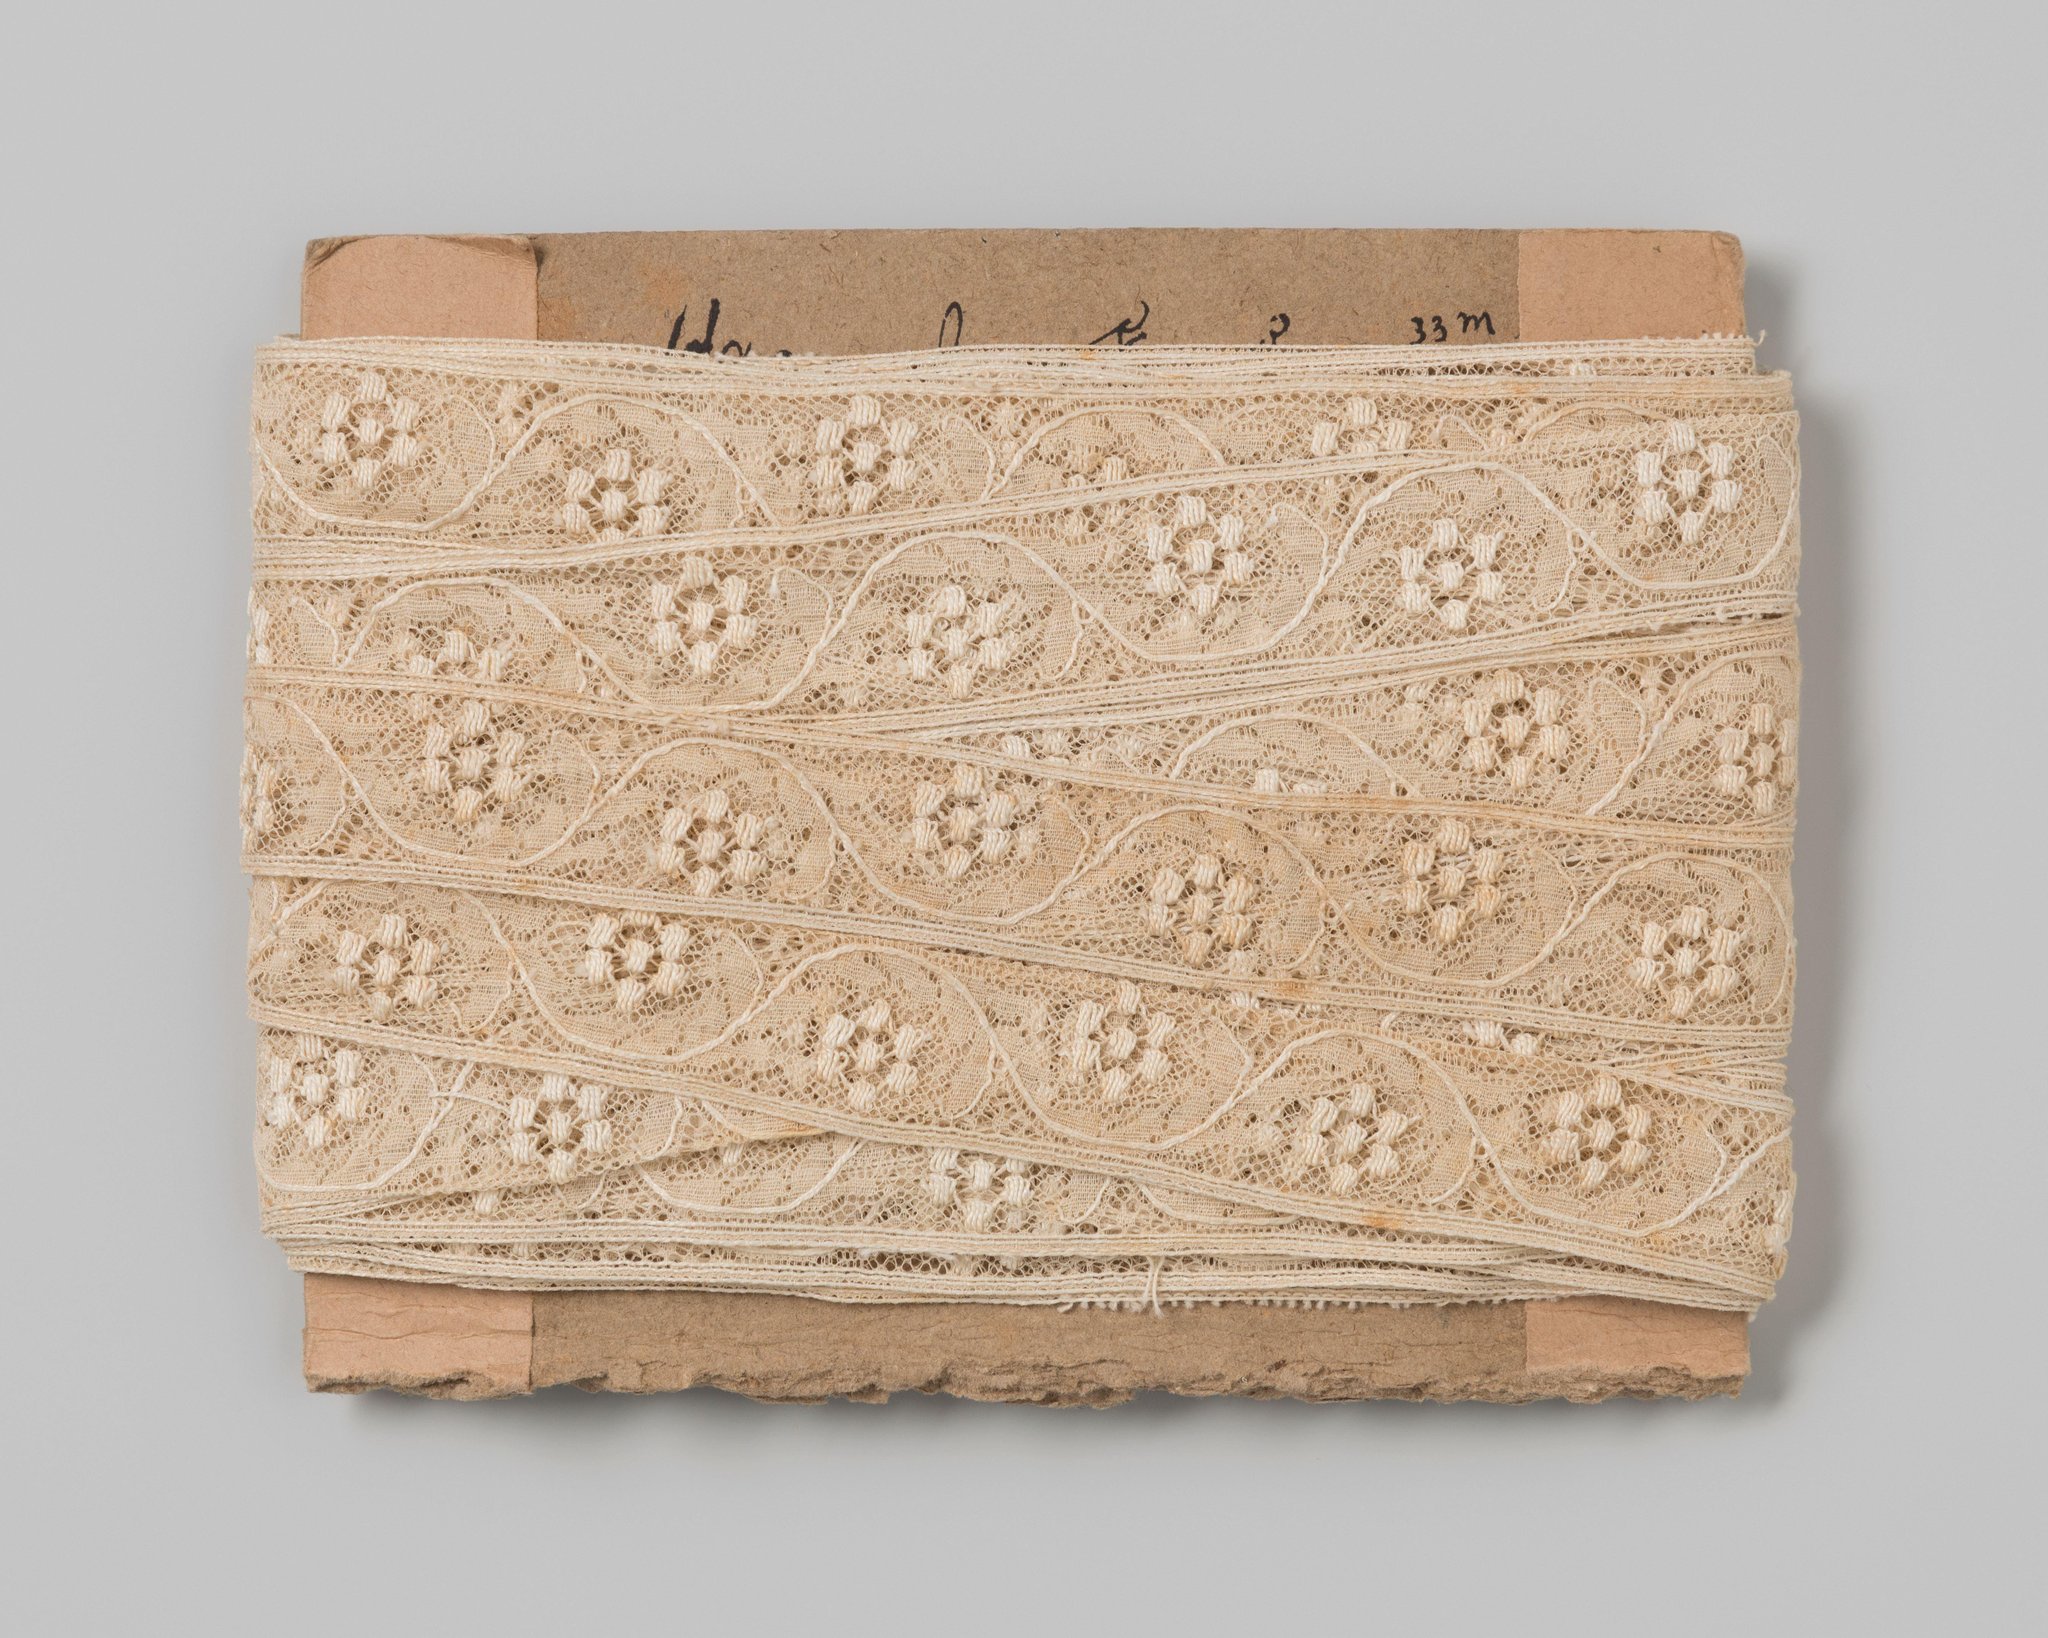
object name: entre deux, tussenzetsel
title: Tussenzetsel van kant met floraal motief op karton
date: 1920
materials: cardboard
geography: nijmegen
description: Tussenzetsel van kant met floraal motief op karton.